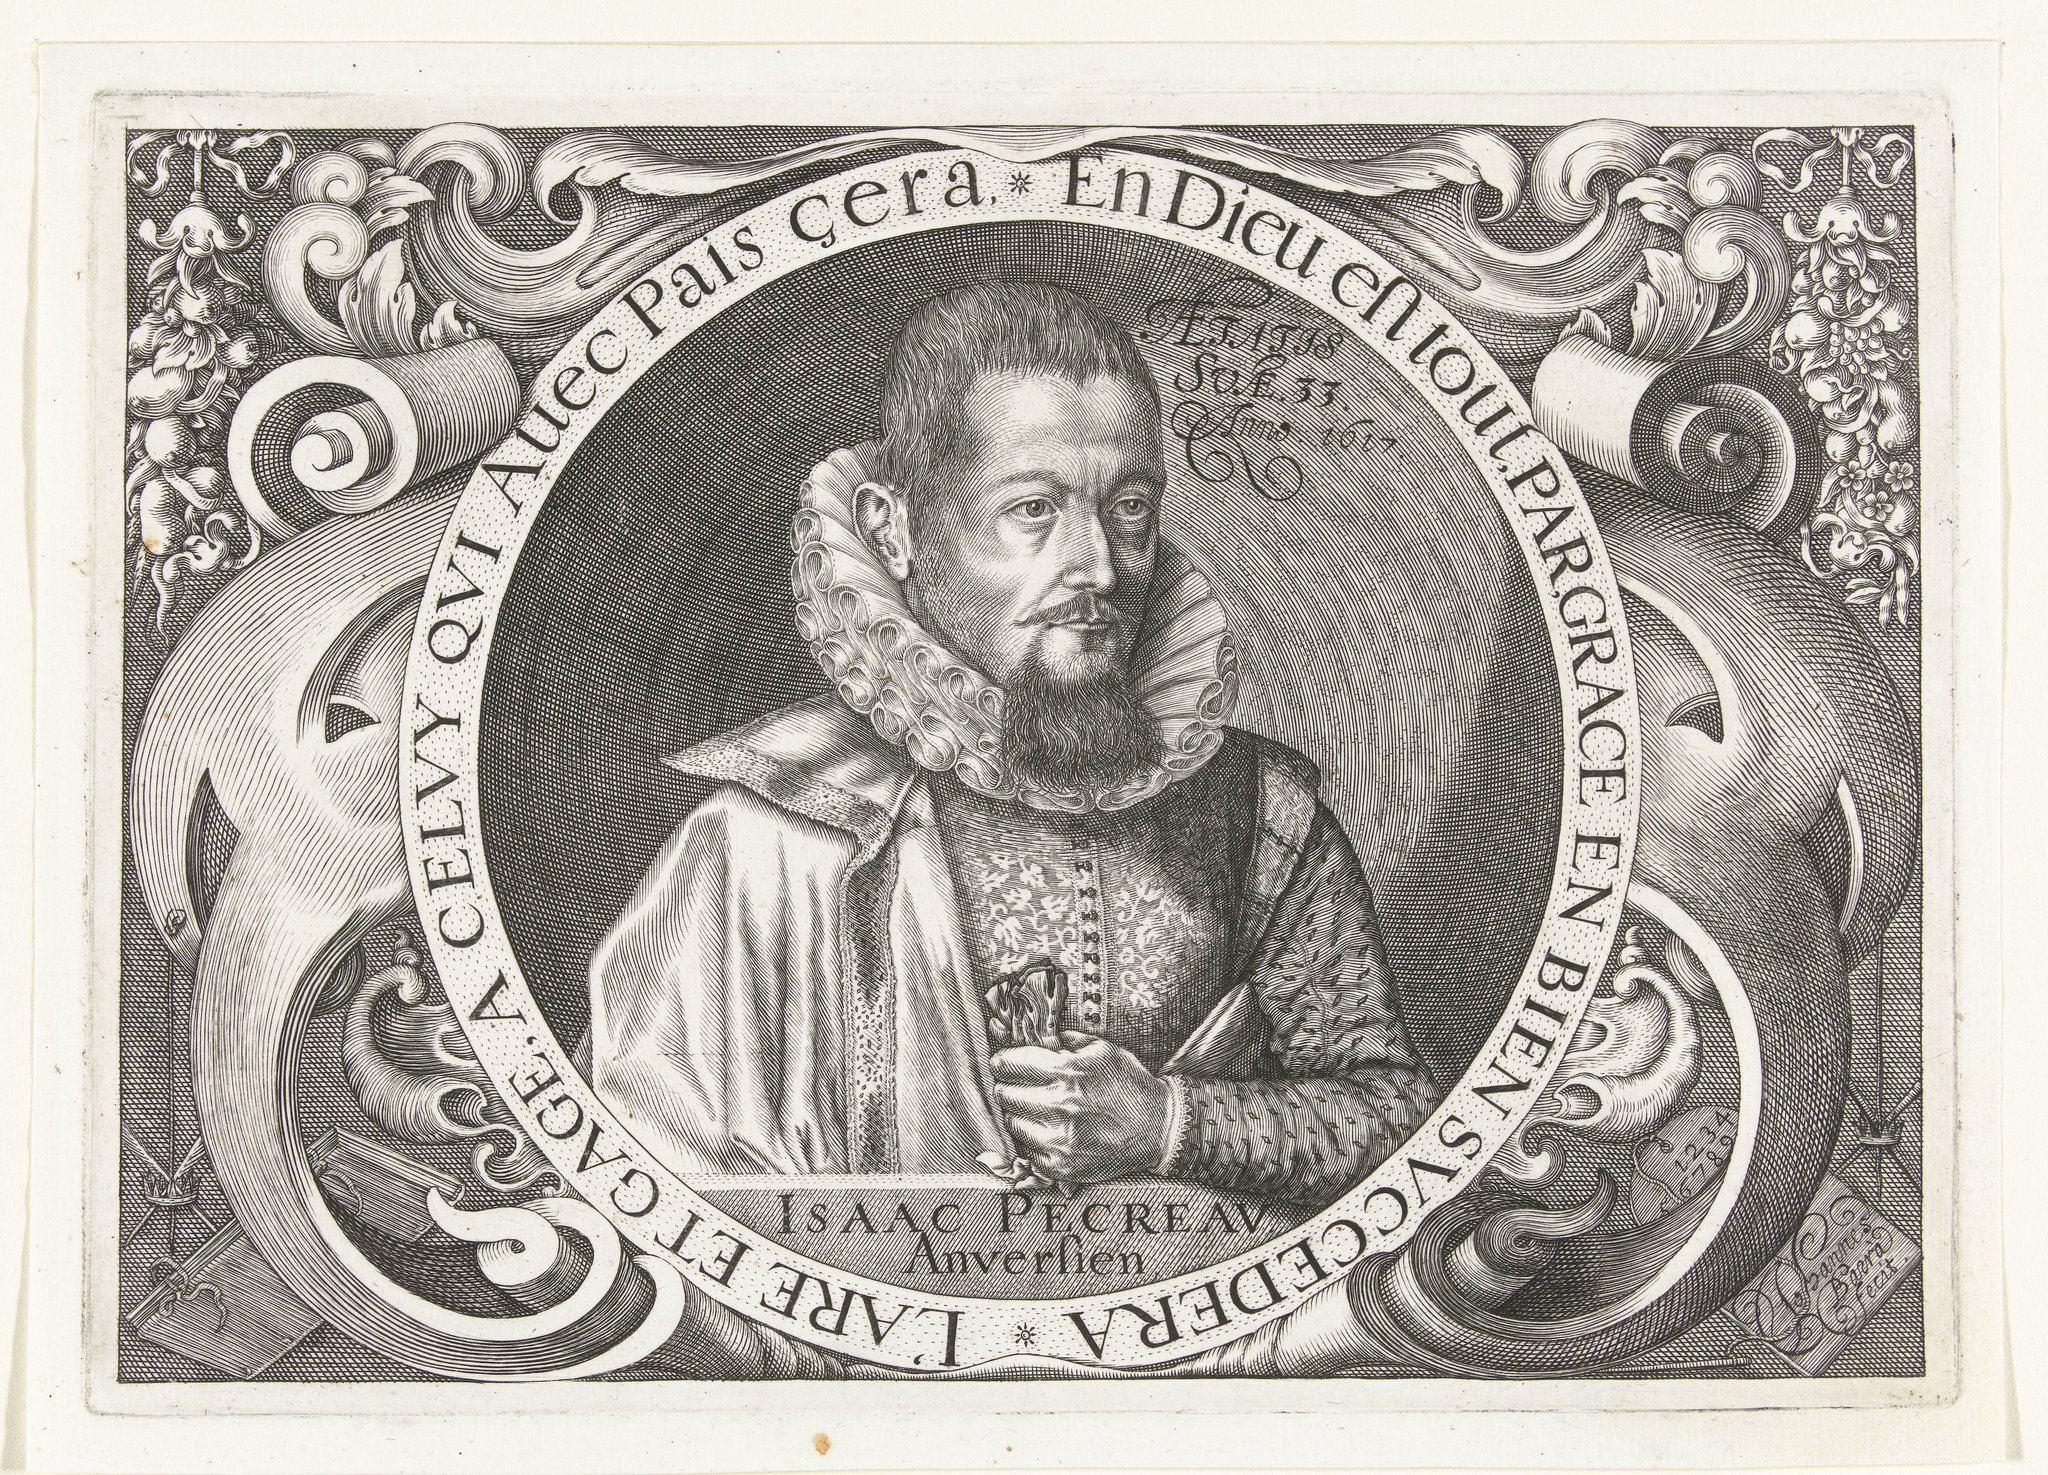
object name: print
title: Portret van Isaac Pecreau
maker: johan barra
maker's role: print maker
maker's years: 1581-1634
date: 1617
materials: paper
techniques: engraving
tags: neck-gear ~ clothing (with name) (+ men's clothes), cape (+ men's clothes), clothing for the upper part of the body (+ men's clothes), gloves, mittens, etc. (+ men's clothes), beard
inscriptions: date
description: Buste van Isaac Pecreau met geplooide kraag, mantel over zijn schouder en handschoenen in zijn hand. Portret op 33-jarige leeftijd aldus het opschrift. In ronde omlijsting met randschrift in ornament met rolwerk en festoenen. De kunstenaar heeft zijn naam gesigneerd op een lei met een griffel.